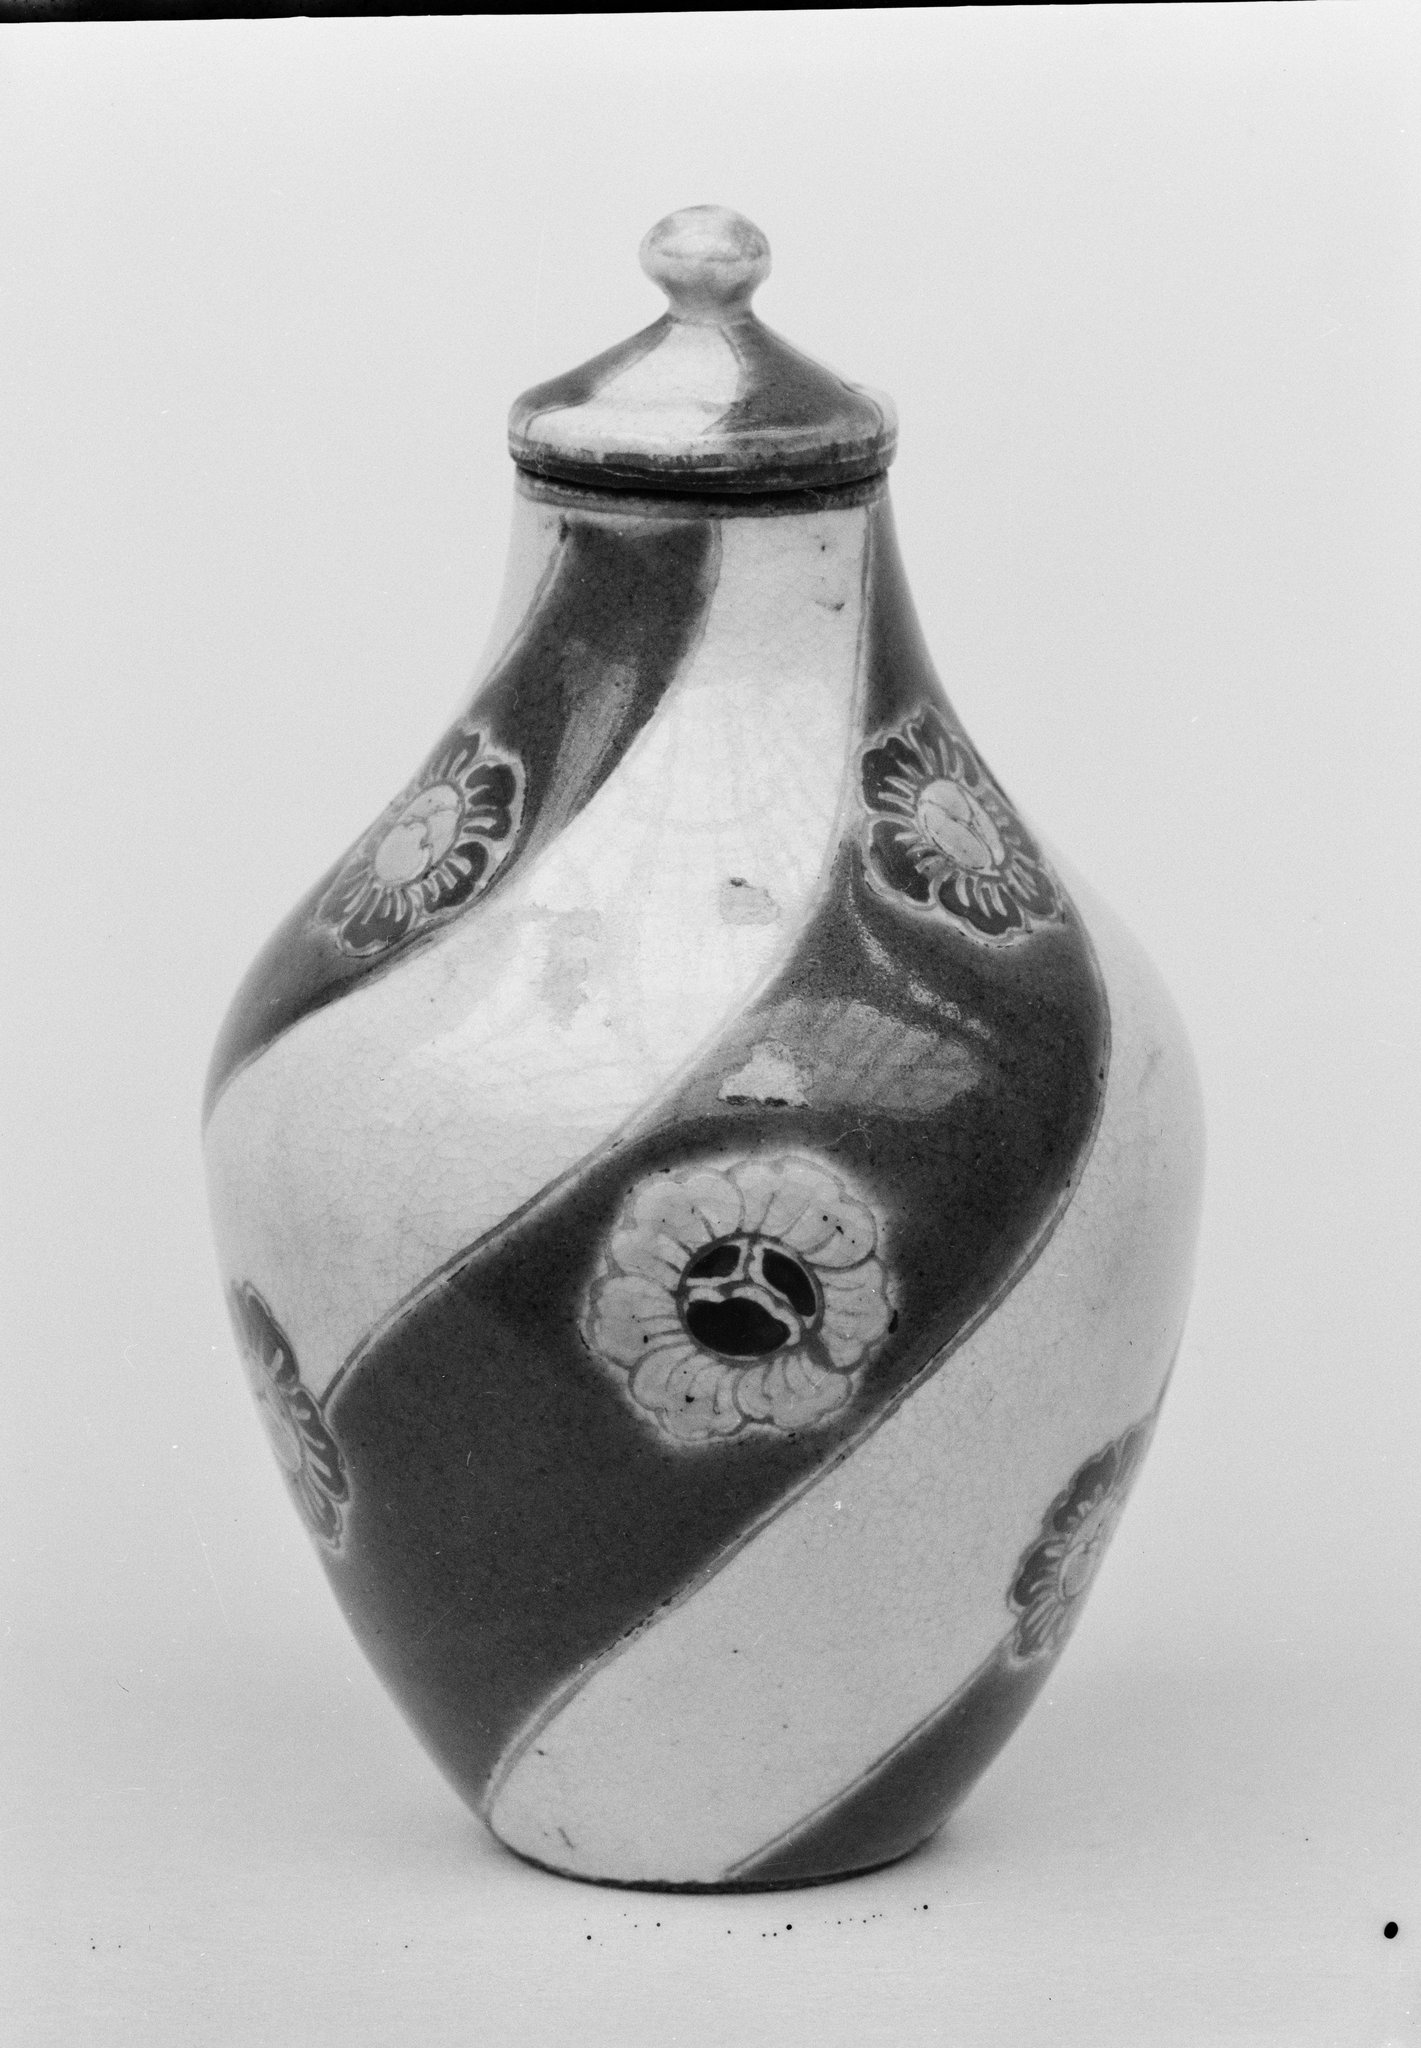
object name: jar with cover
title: Miniature Jar with Cover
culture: japanese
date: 1767-1800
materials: enamel, glaze, porcelain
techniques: enamel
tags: flowers